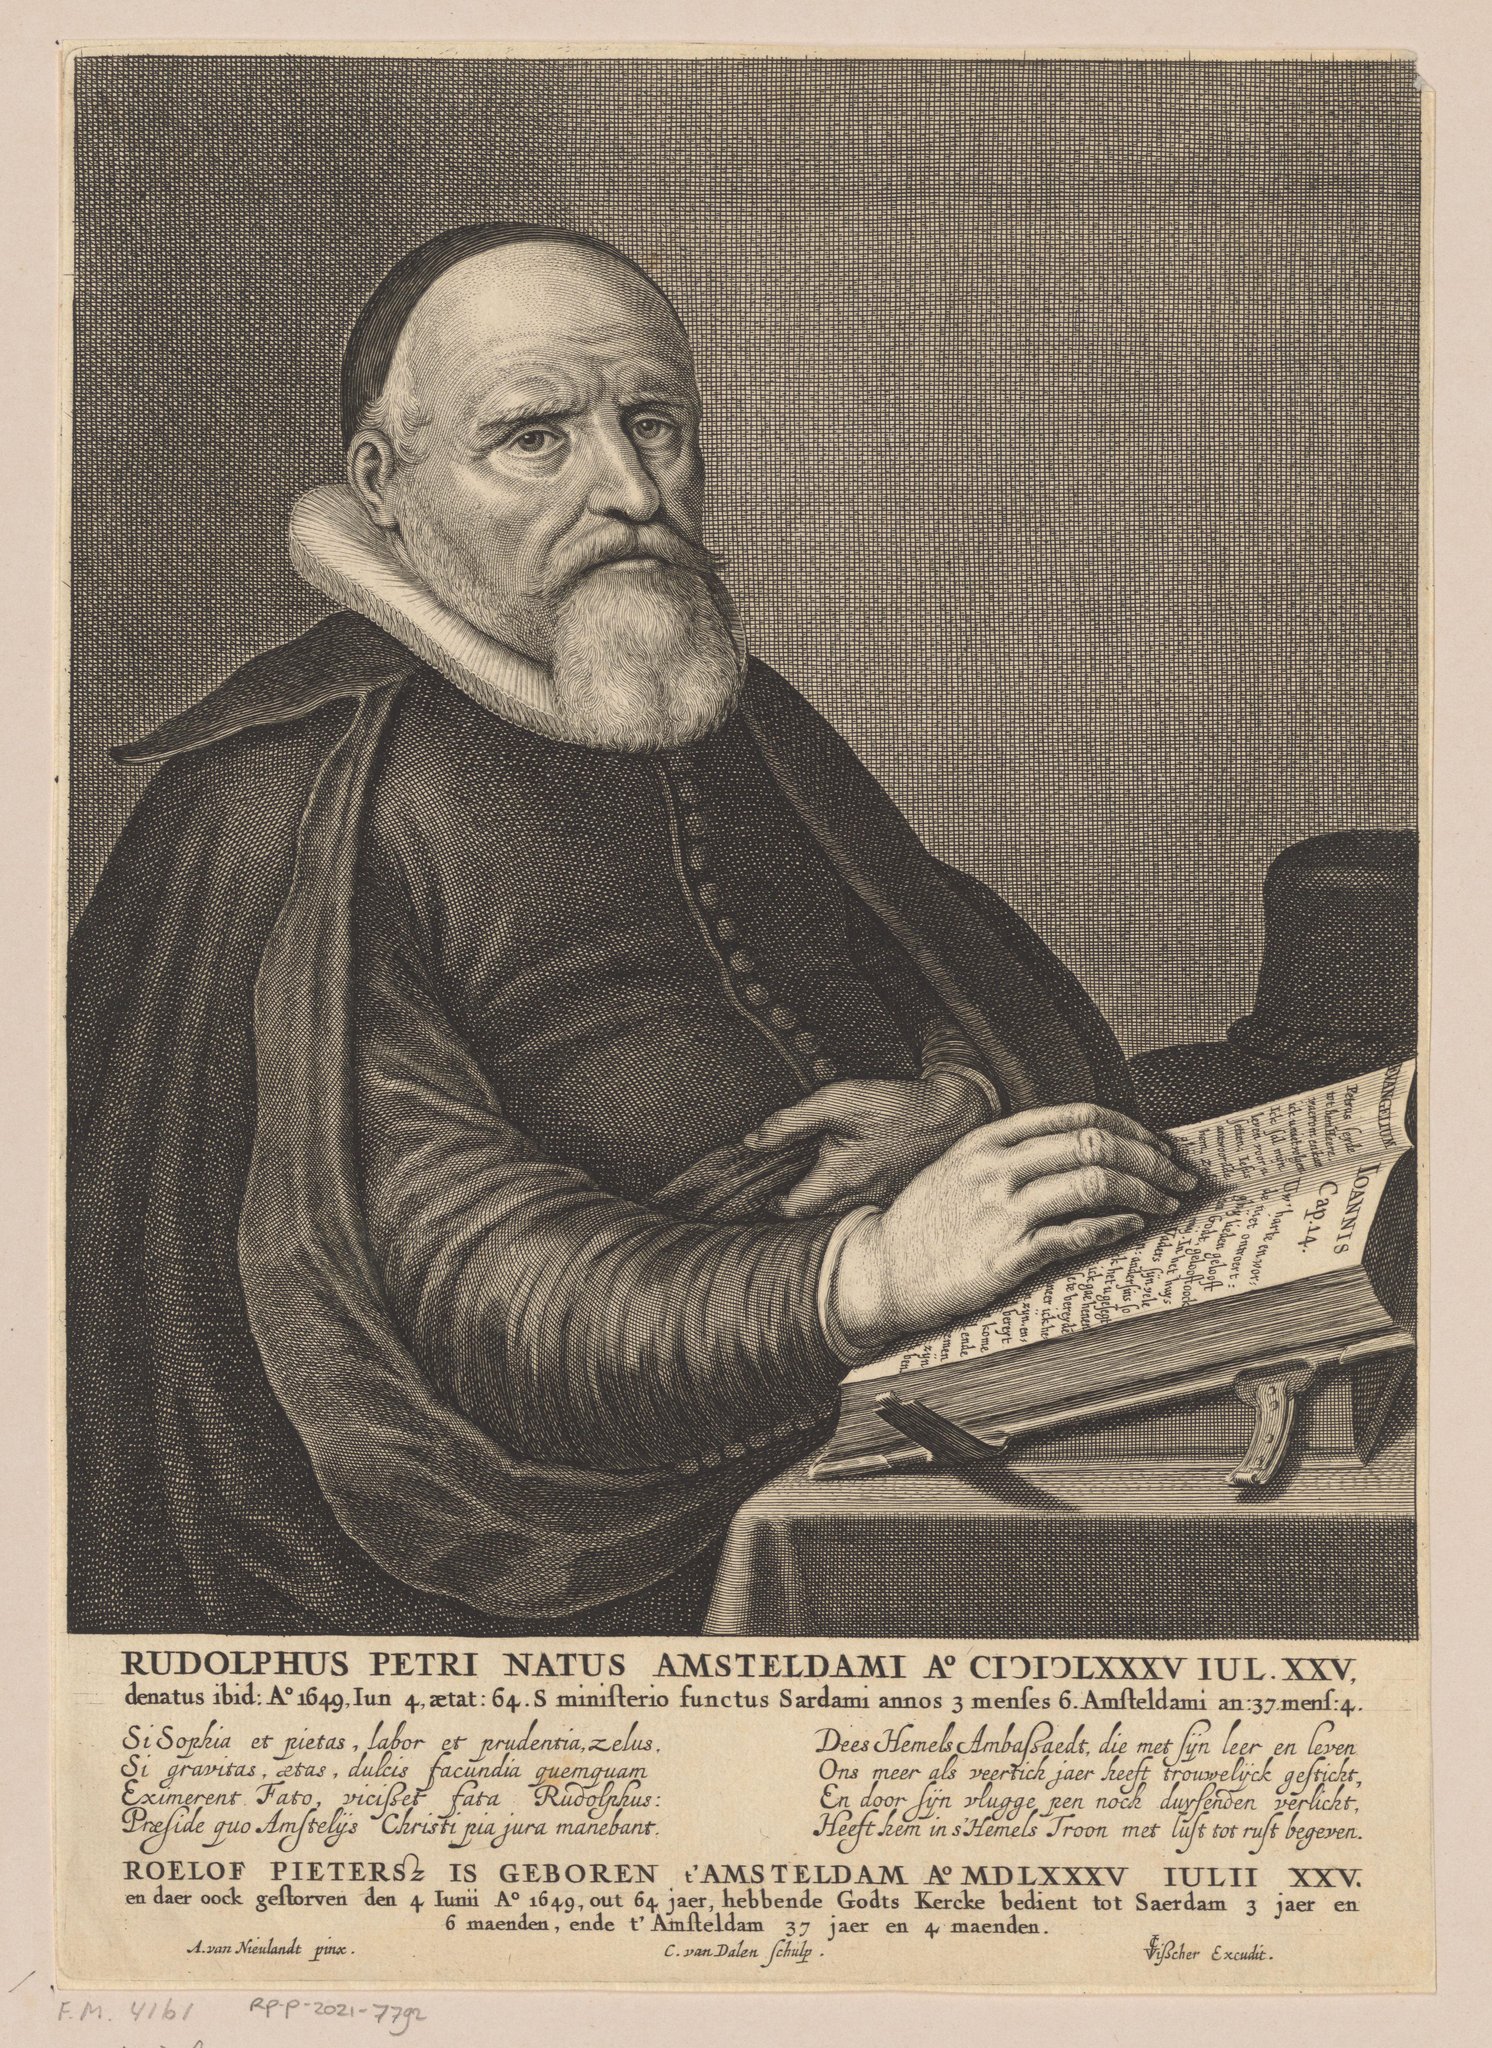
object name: print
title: Portret van Rudolphus Petri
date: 1649-1665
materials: paper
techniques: engraving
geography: amsterdam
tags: amsterdam, historical persons, book - mm - book open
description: Onder in de marge Latijns en Nederlands vers.